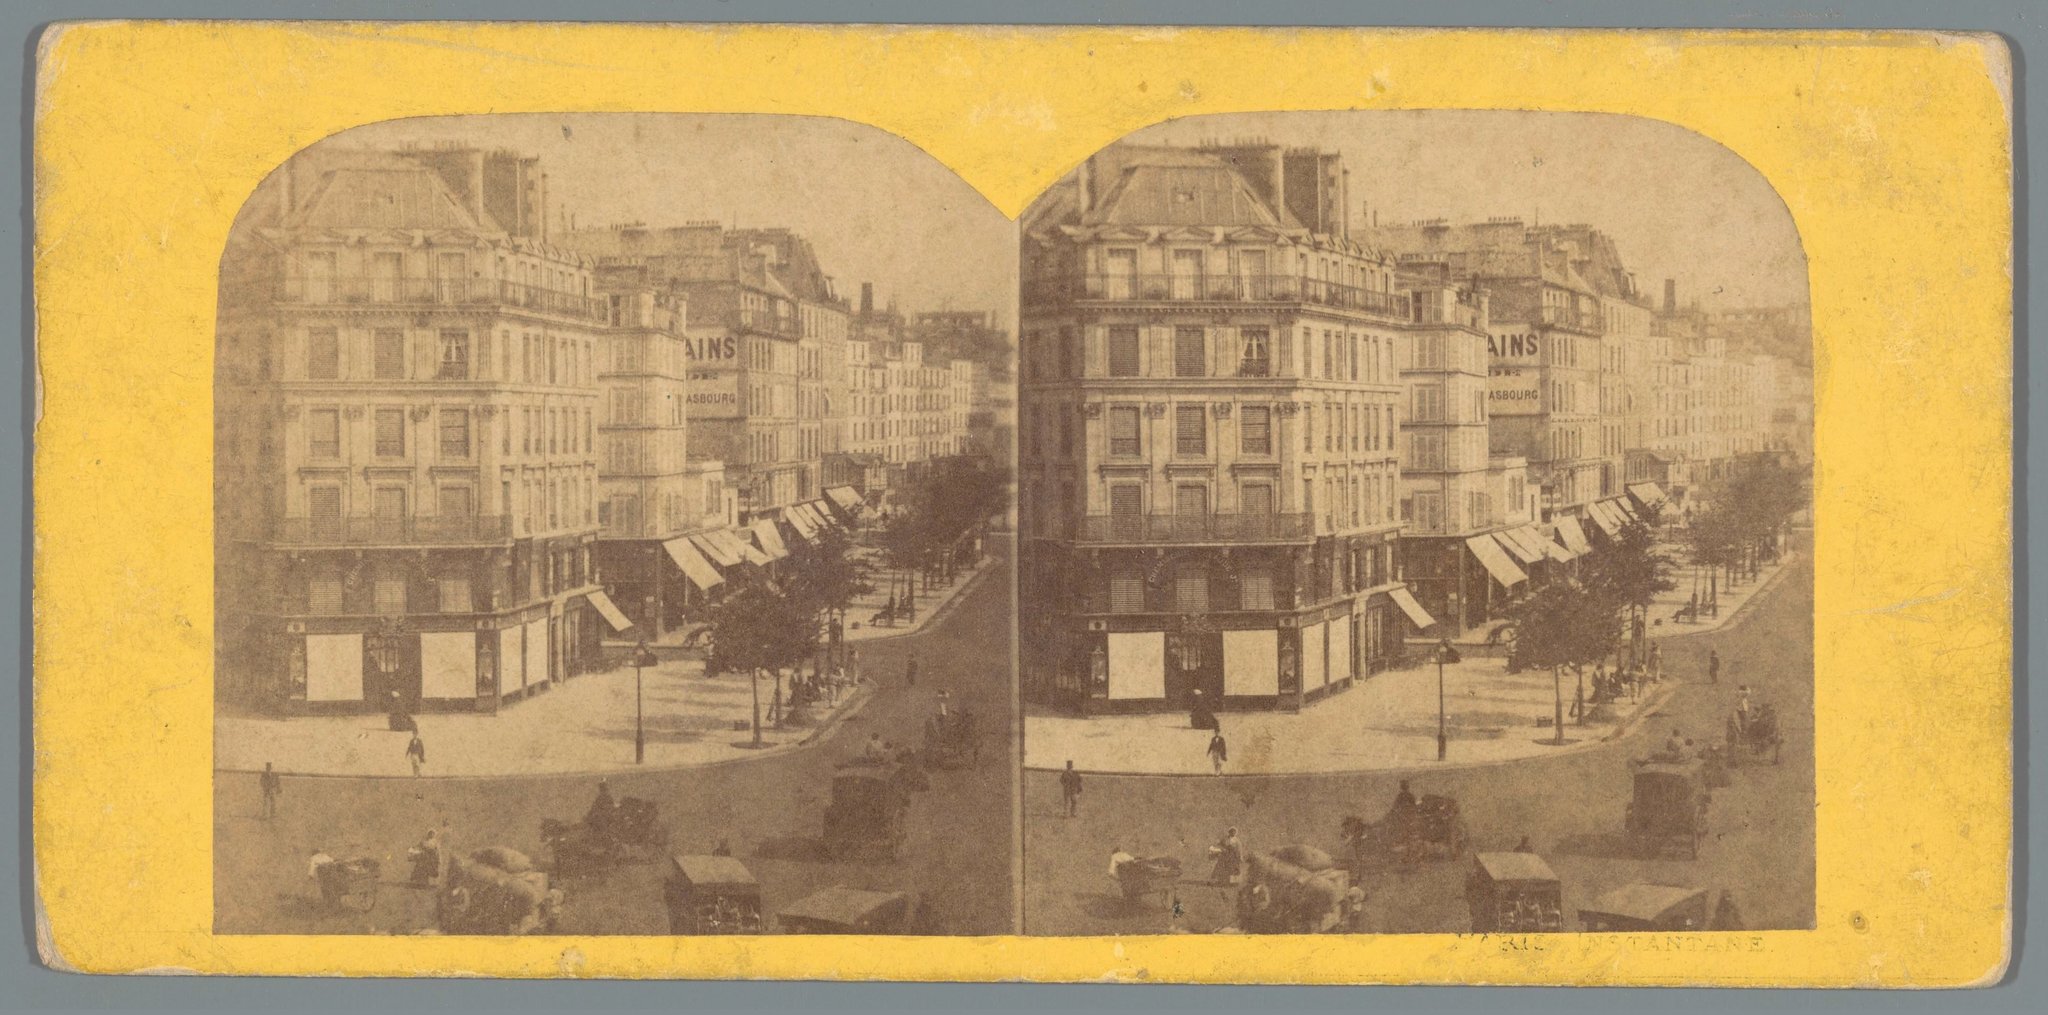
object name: stereograph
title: Gezicht op Boulevard de Strasbourg in Parijs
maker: Anonymous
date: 1850-1880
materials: cardboard, photographic support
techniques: albumen print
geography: paris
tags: animal traction, animal-drawn vehicle (carriage etc.), street, shop-window, show-window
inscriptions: inscription: ‘Boulevart de Strasbourg’